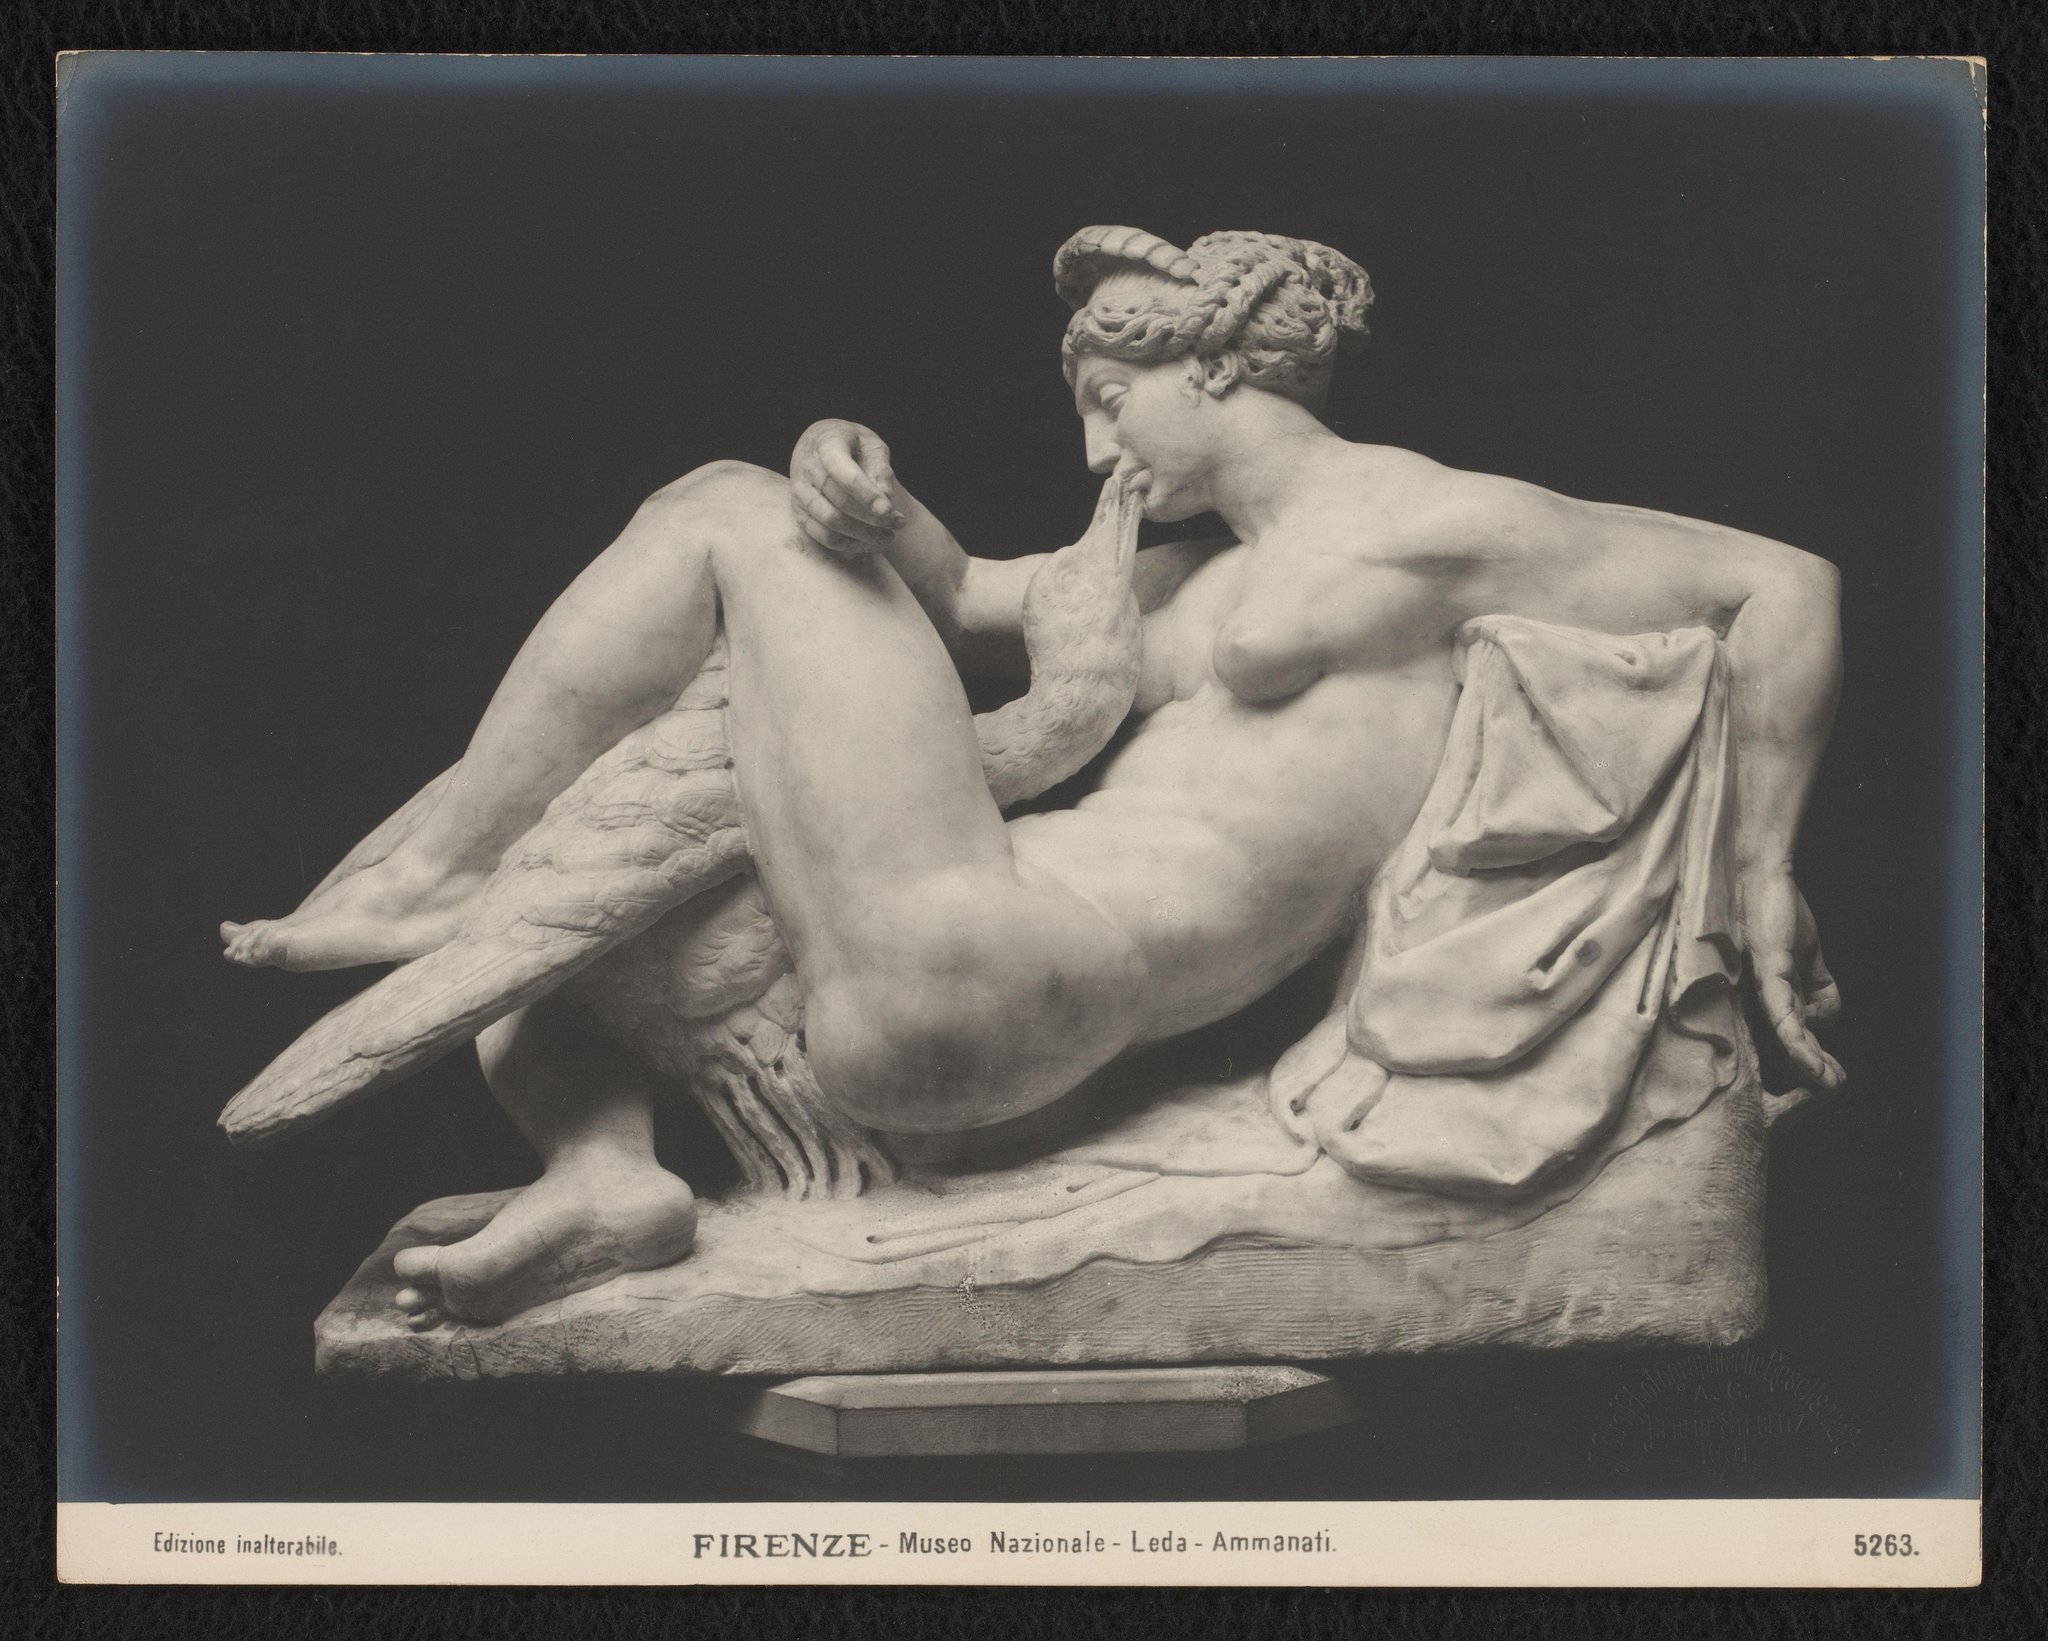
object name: photograph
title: Firenze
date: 1901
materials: paper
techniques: gelatin silver print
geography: berlin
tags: jupiter, in the shape of a swan, and leda, piece of sculpture, reproduction of a piece of sculpture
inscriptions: inscription: ‘Edizione inalterabile.’, number: ‘5163.’, collector's mark: ‘RIJKS SCHOOL VOOR KUNSTNIJVERHEID/ GROEP’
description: Deze foto maakt deel uit van een omslag.